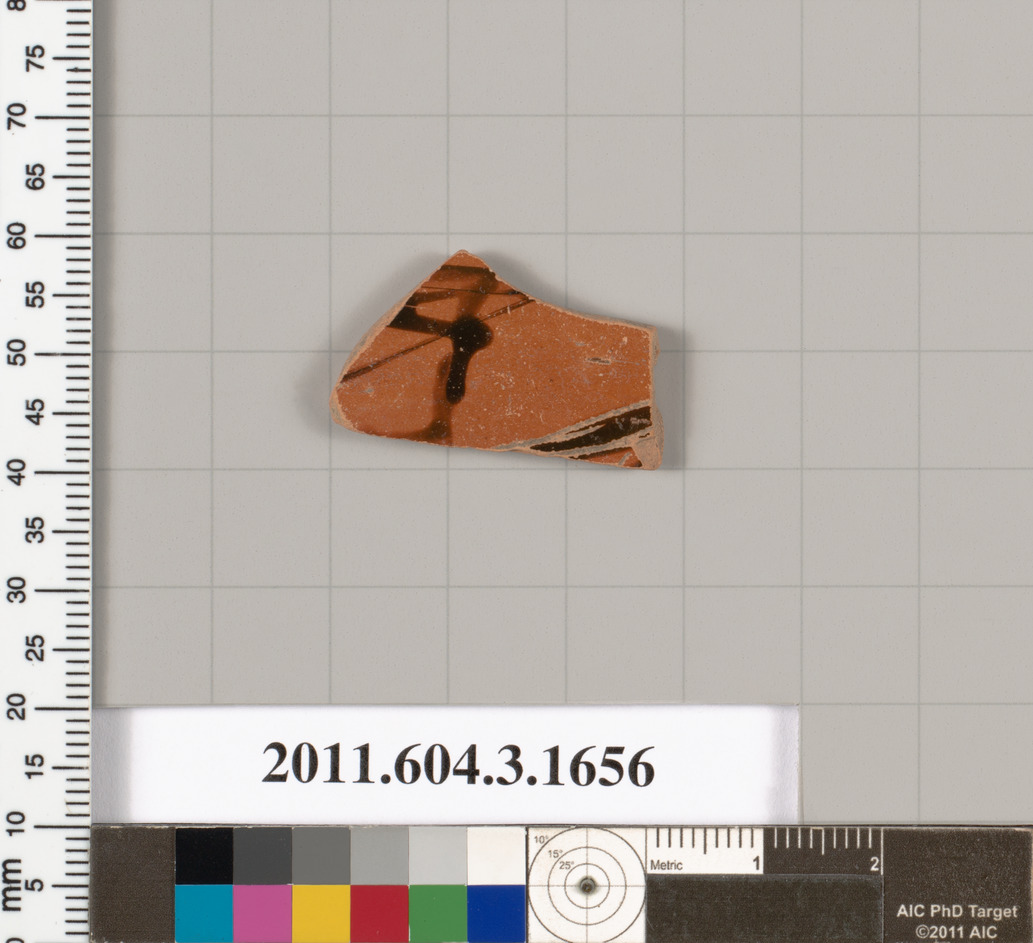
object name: kylix fragment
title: Terracotta fragment of a kylix: Band cup (drinking cup)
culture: greek, attic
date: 550-526 BCE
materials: terracotta